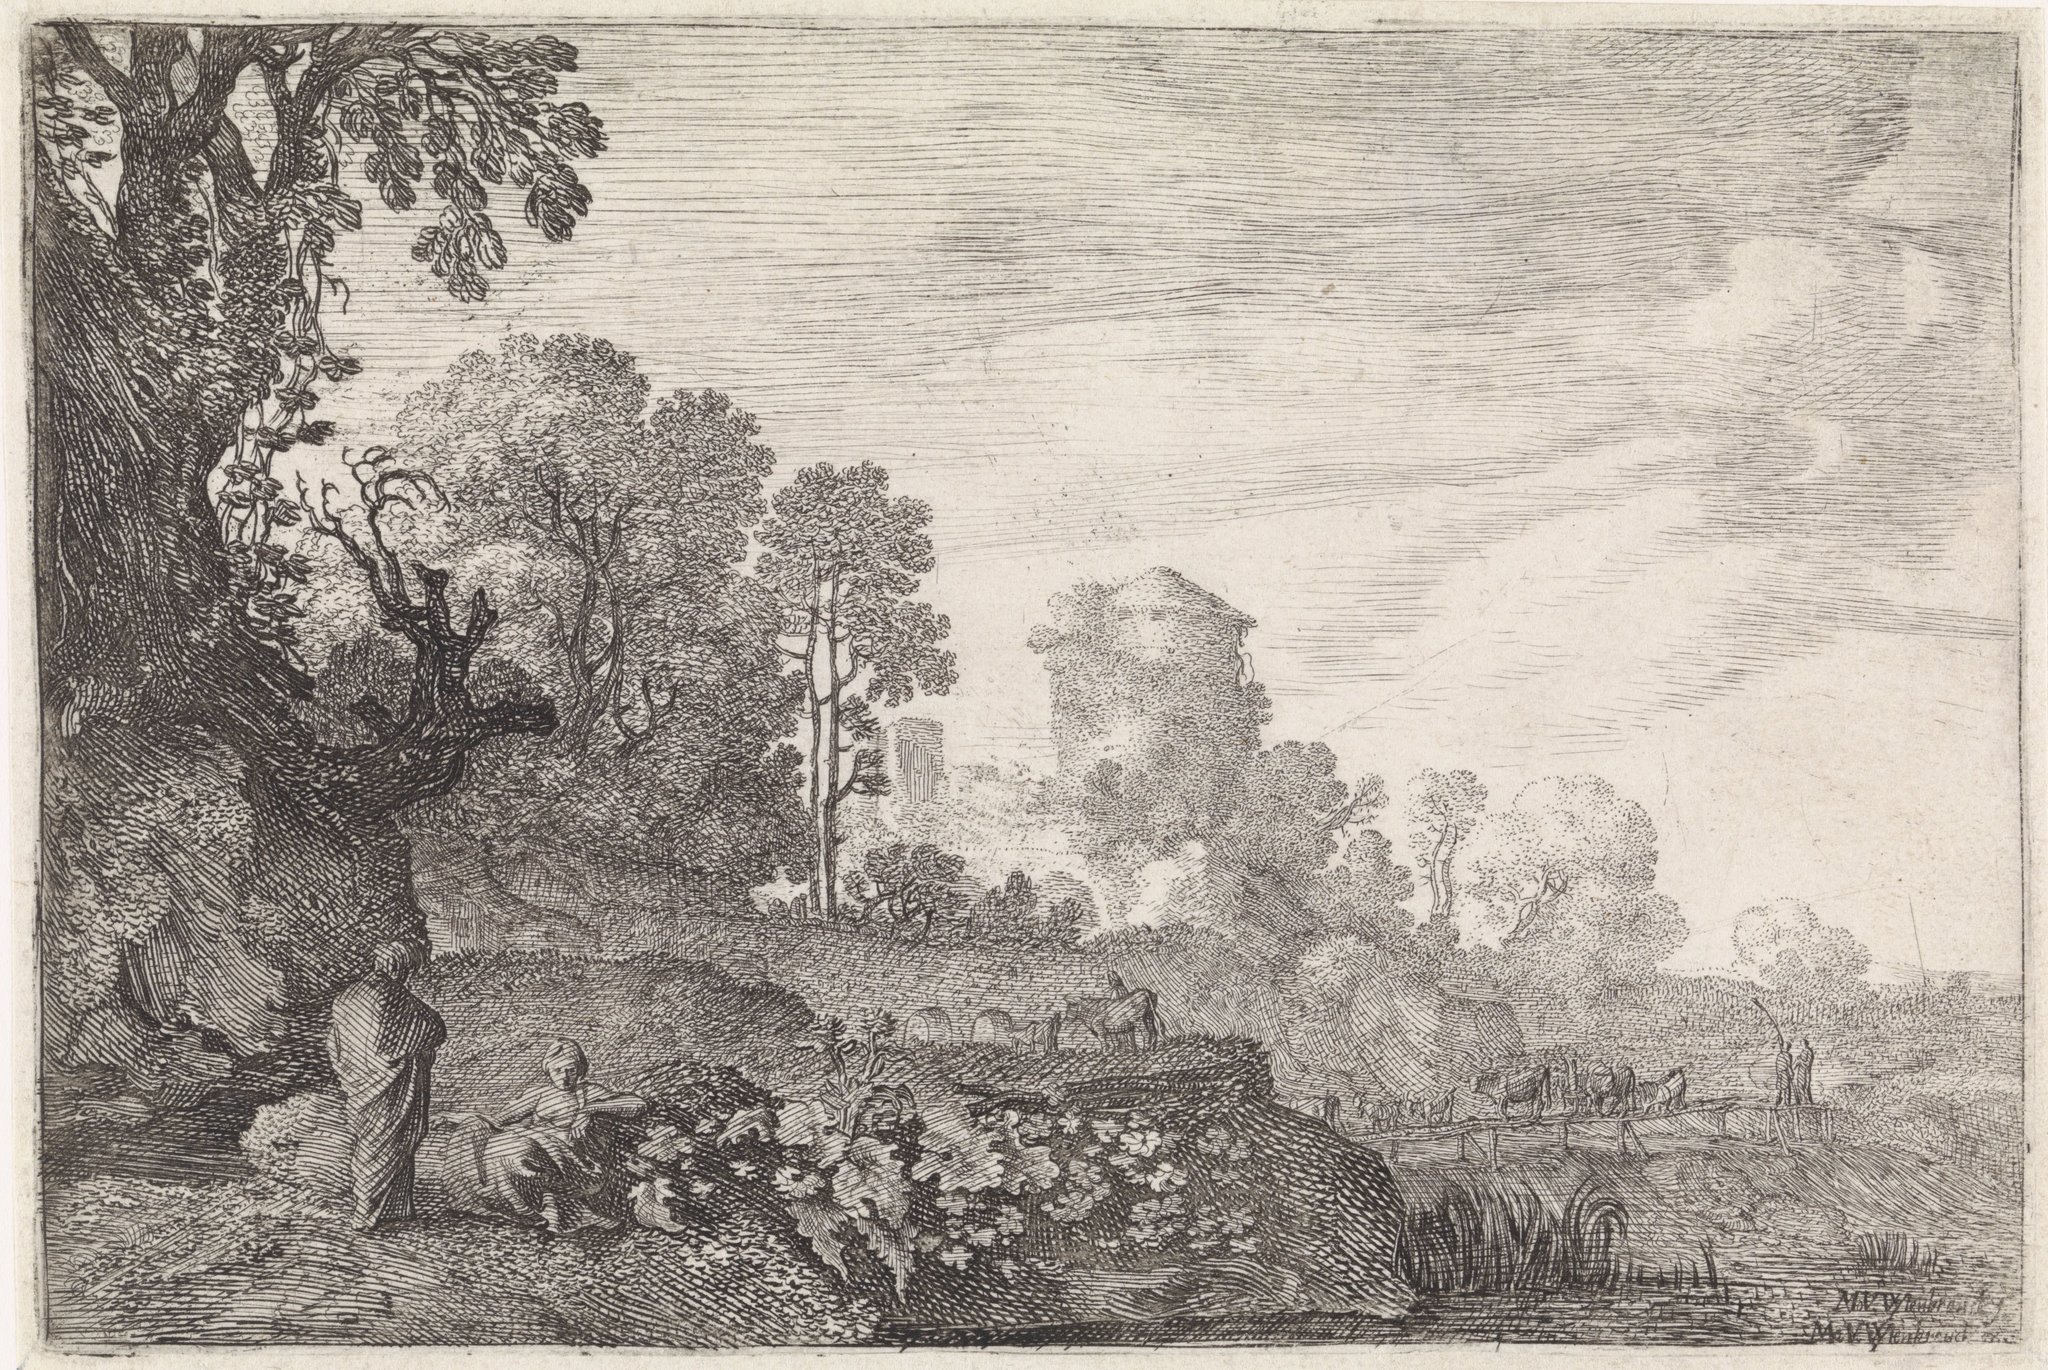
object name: print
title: Arcadische landschappen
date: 1600-1647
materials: paper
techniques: engraving, etching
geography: antwerp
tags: pastorals, arcadian scenes, herd, flock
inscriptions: collector's mark: Lugt 240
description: Een kudde met herders trekt over een eenvoudige houten brug, die over een brede waterval voert. Daarachter staat een stenen boogbrug en een hoge, ronde toren. Op de voorgrond een man en een vrouw.